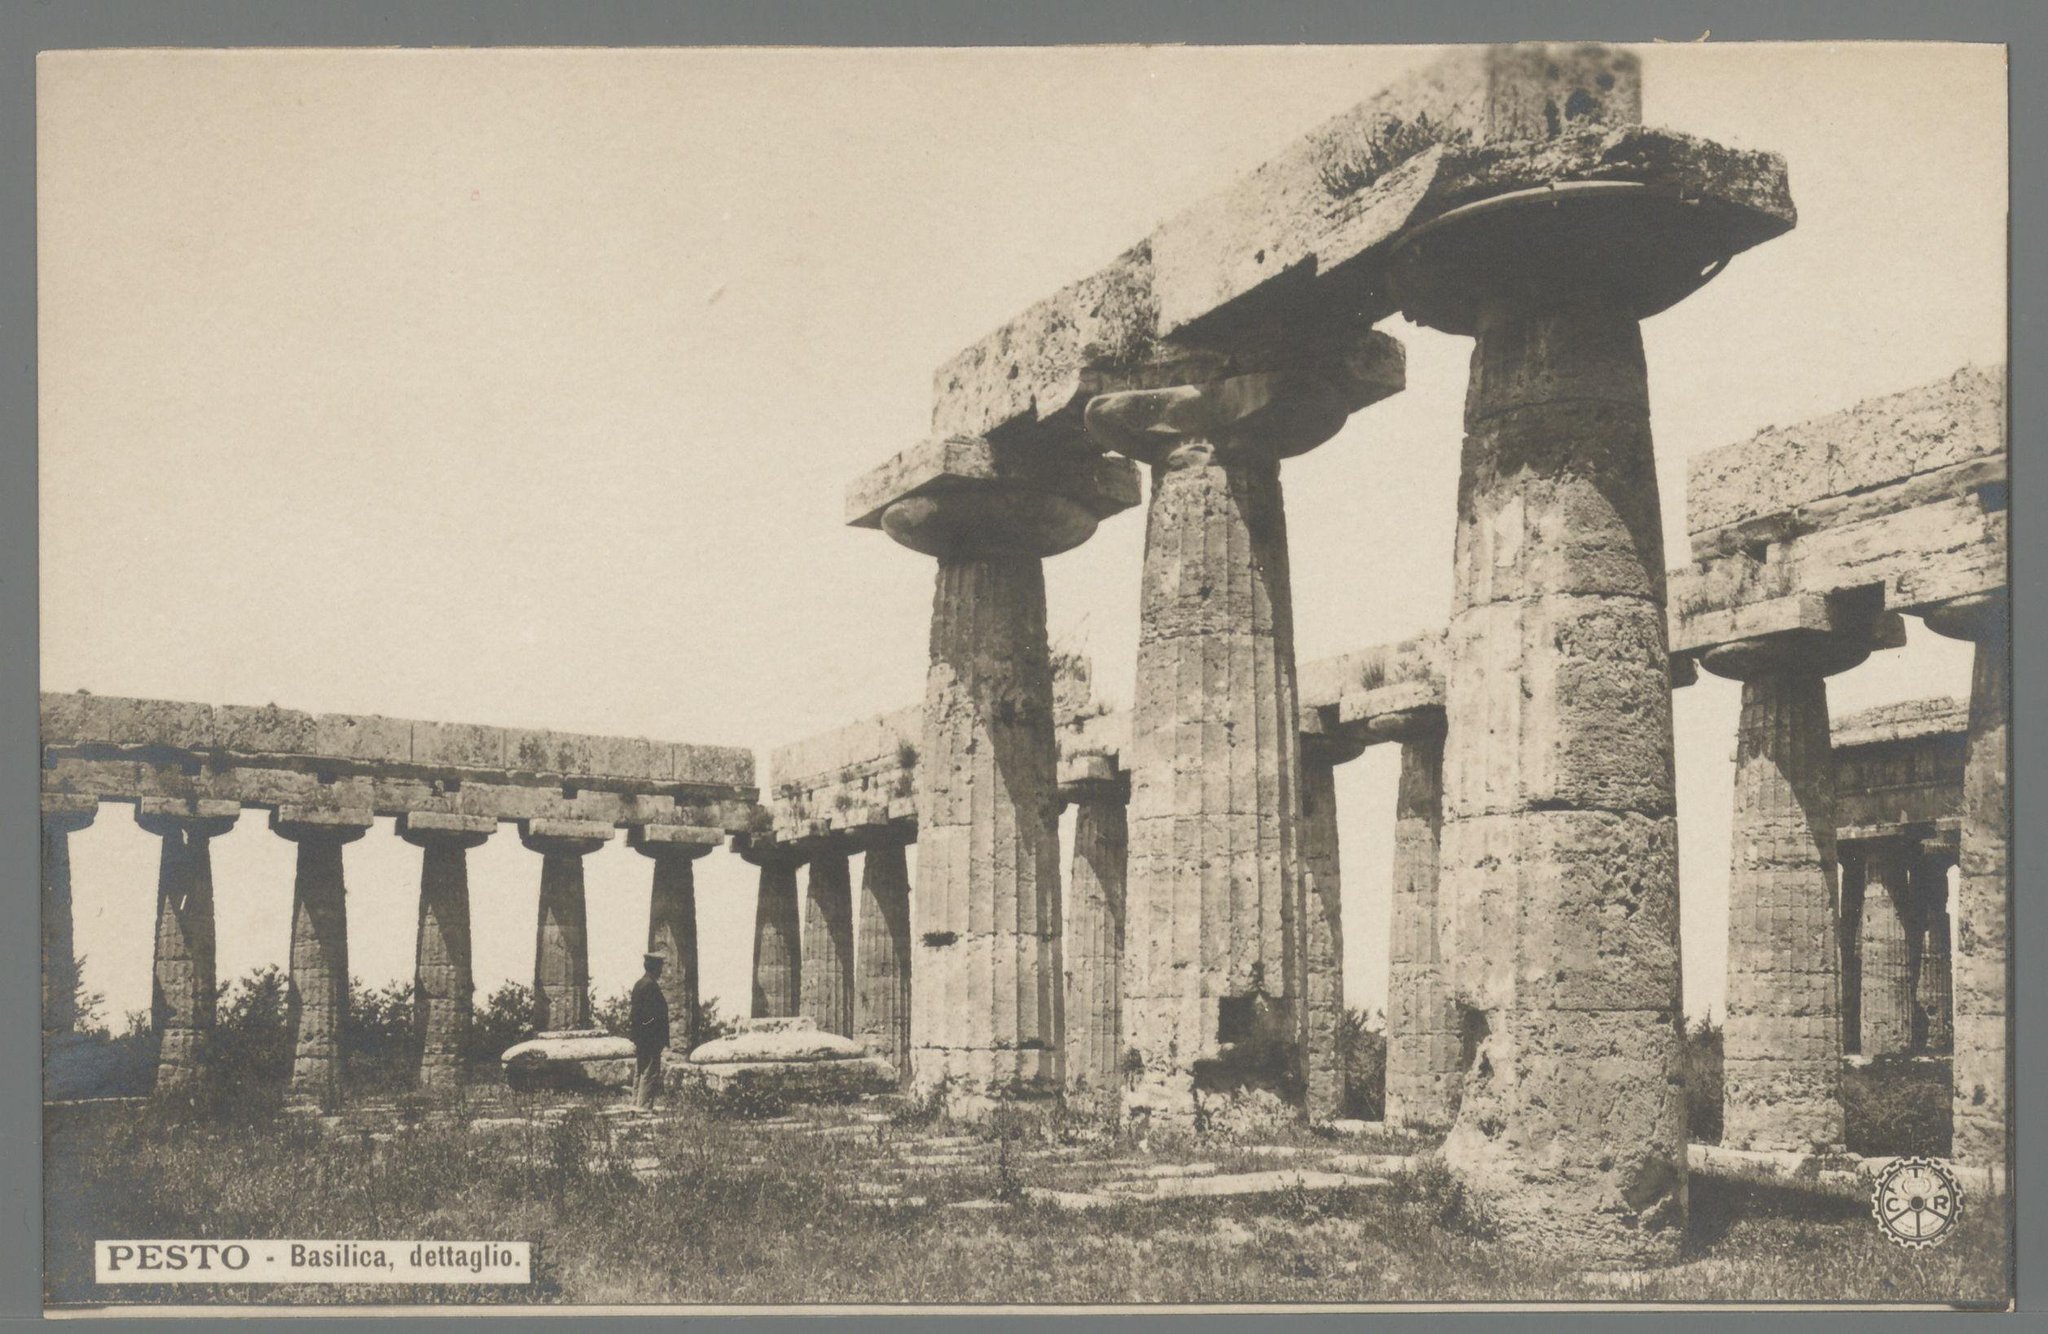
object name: ansichtkaart, prentbriefkaart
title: Pesto. Basilica, dettaglio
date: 1900-1906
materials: photographic support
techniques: photography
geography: italy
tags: column, pillar ~ architecture, temple, shrine ~ roman religion